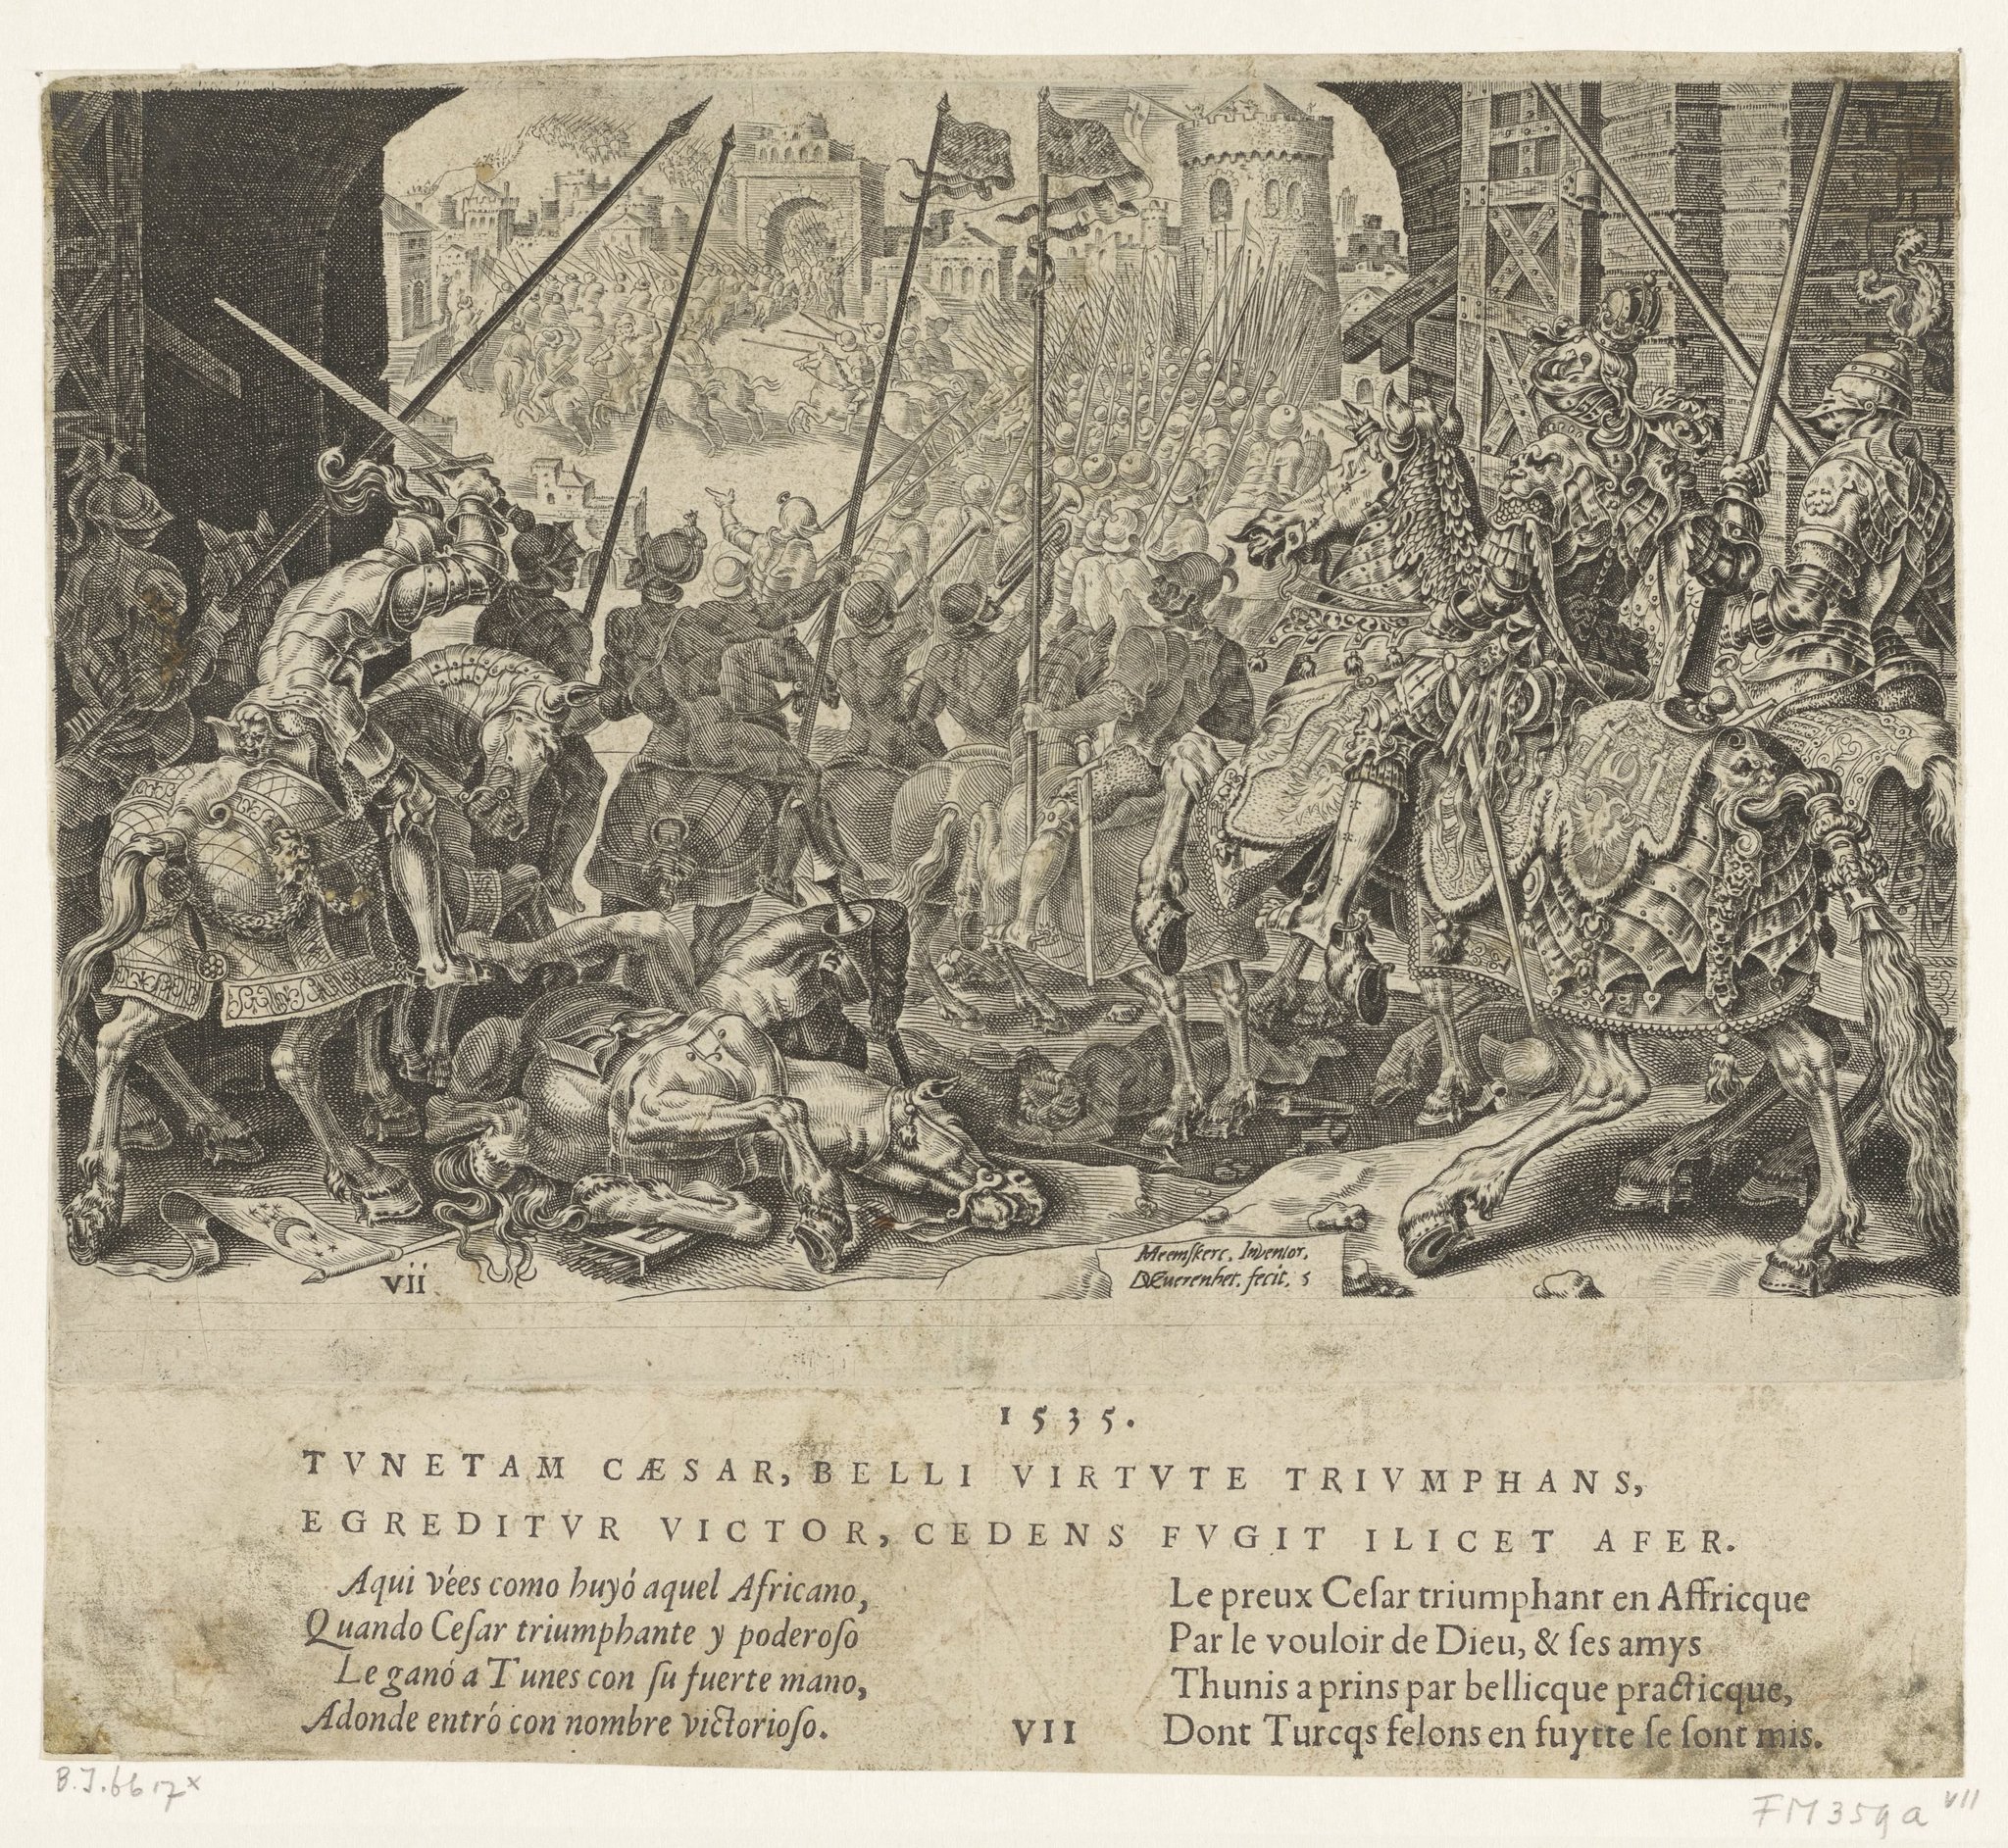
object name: history print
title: Verovering van Tunis, 1535, nr. 7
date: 1555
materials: paper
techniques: engraving, etching, letterpress printing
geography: northern netherlands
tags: ghent, charles v (holy roman emperor and king of spain), battle, fighting in general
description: Verovering van Tunis, 1535. De keizerlijke troepen trekken de stad binnen. Onderschriften in twee regels Latijn, vier regels Spaans en vier regels Frans.